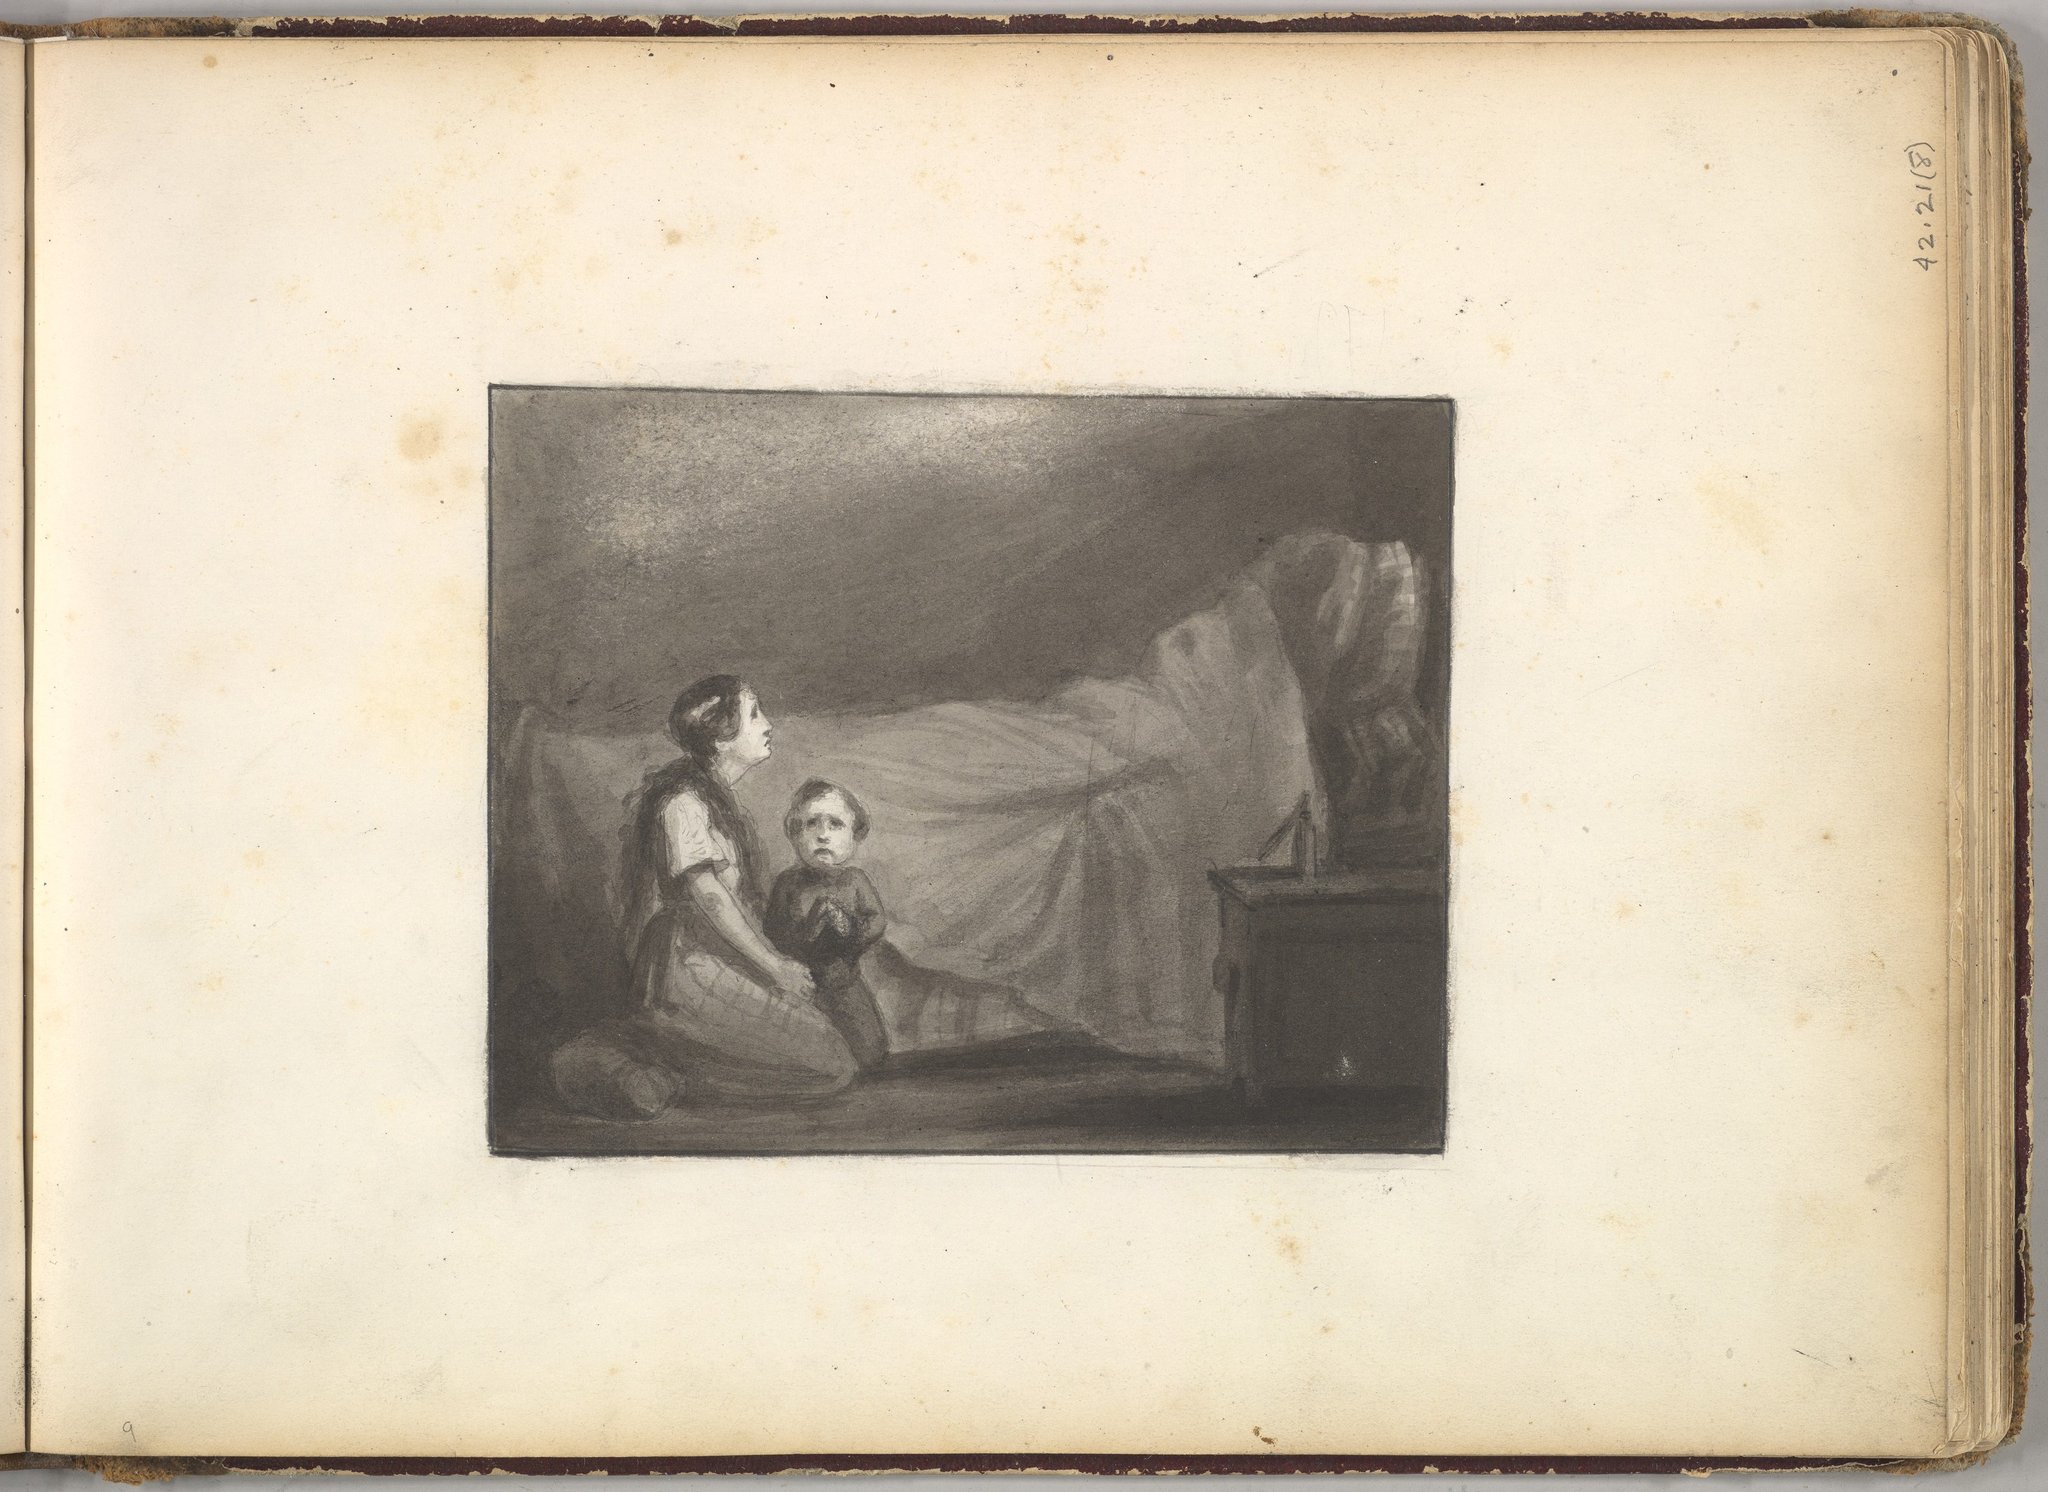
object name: drawing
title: A Deathbed Scene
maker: frederic, lord leighton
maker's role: artist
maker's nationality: british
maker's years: 1830-1896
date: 1849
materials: gouache, ink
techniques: brush, pen, wash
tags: boys,women,death